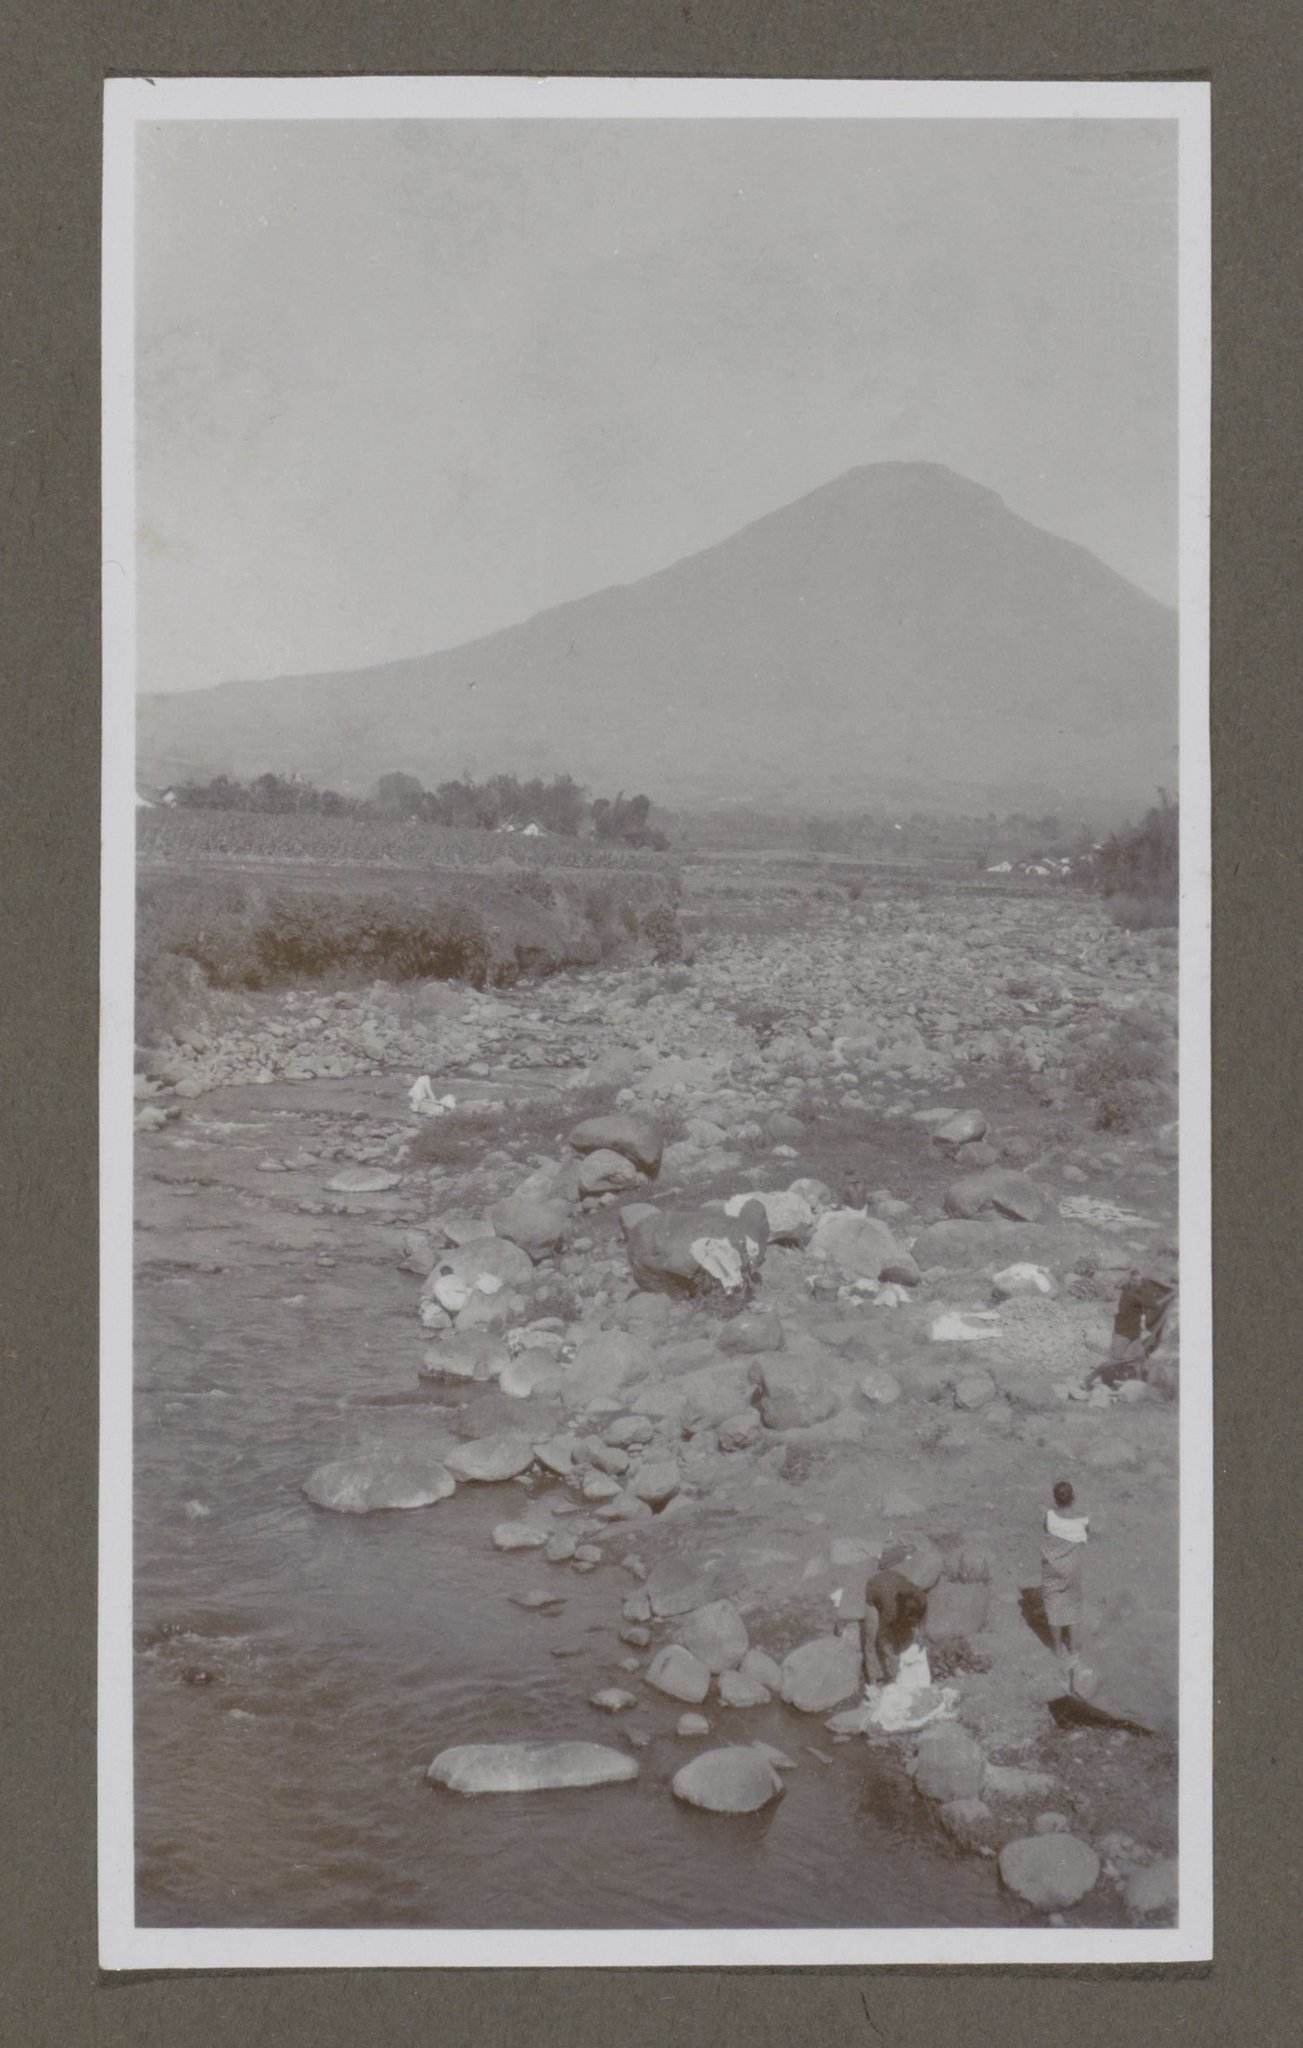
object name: photograph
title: Vulkaan met op de voorgrond mensen bij een beek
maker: Anonymous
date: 1920-1930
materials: photographic support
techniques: gelatin silver print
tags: brook, volcano, dutch east indies, the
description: Onderdeel van familiealbum Nederlands-Indië.